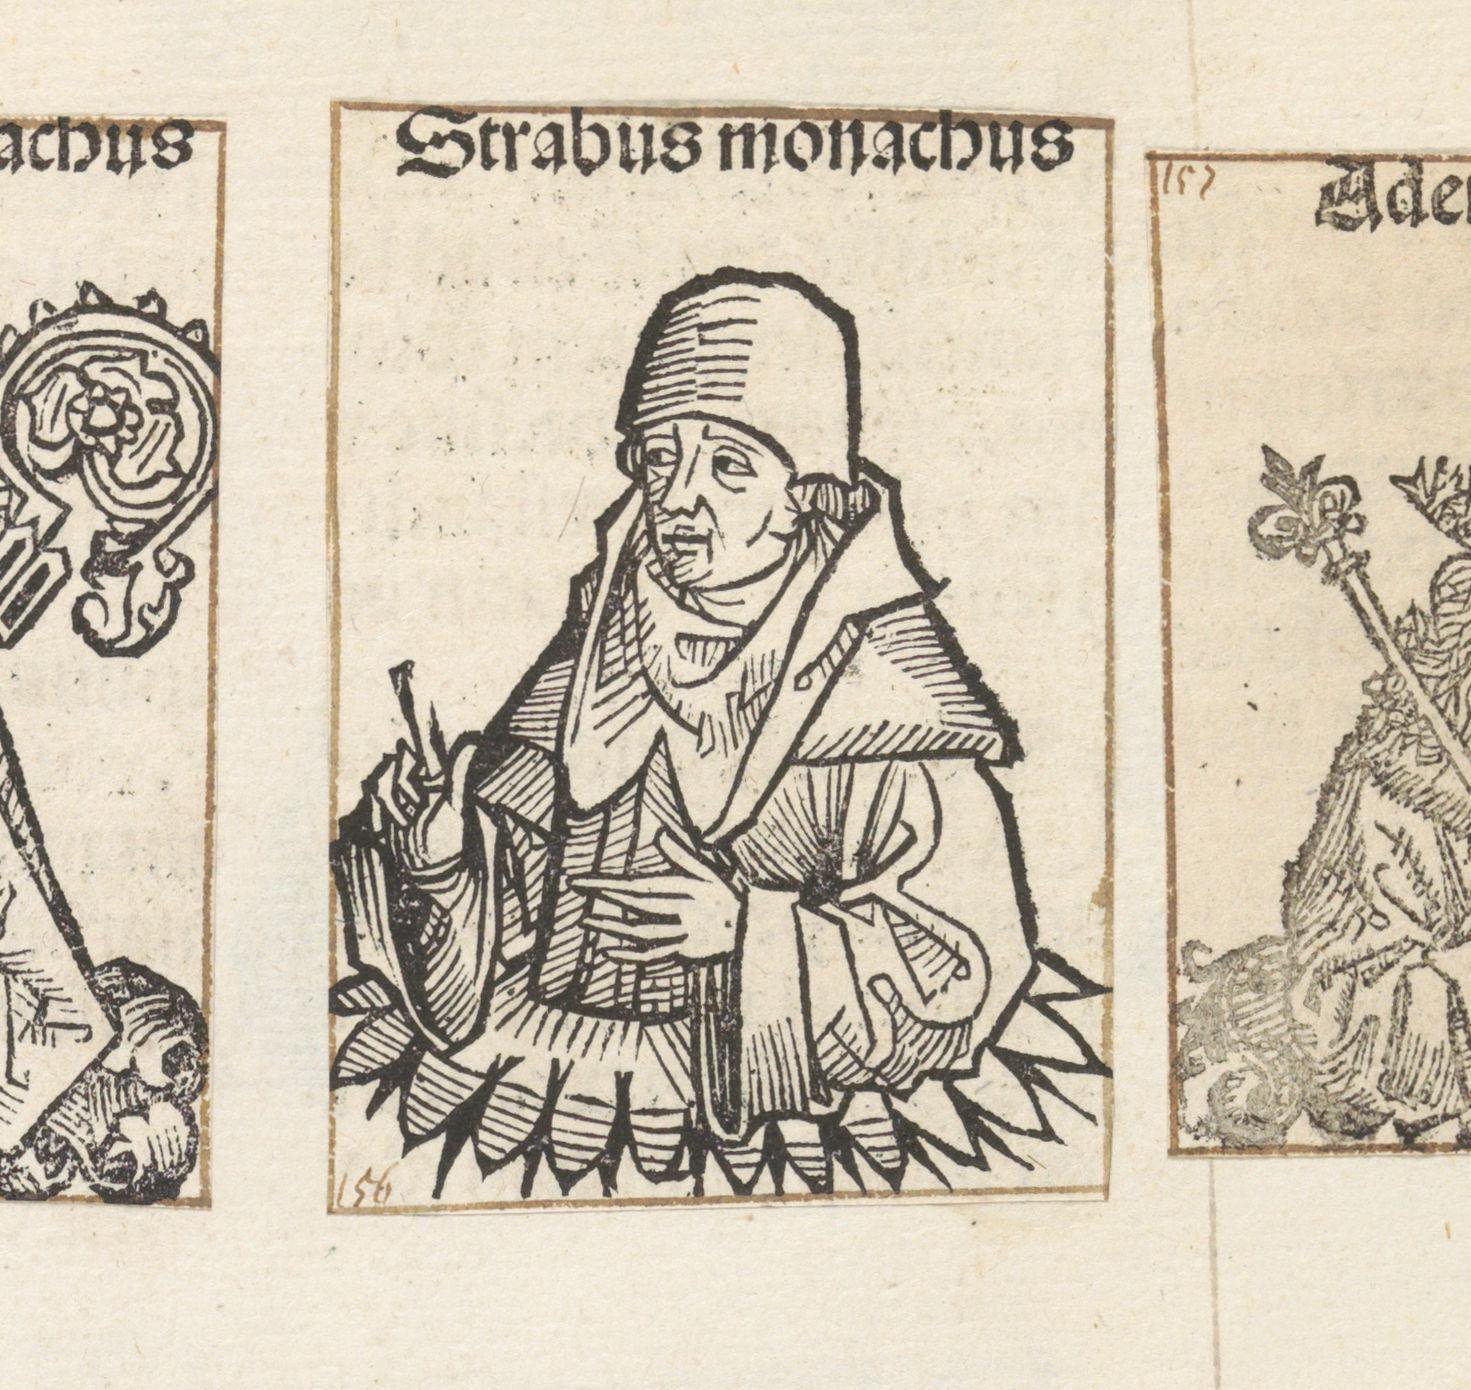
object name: book illustration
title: Walahfrid Strabo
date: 1493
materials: paper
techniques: letterpress printing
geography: nuremberg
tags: archbishop, bishop, etc. (roman catholic)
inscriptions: inscription: ‘156’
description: De houtsnede wordt herhaaldelijk gebruikt als boekillustratie in de Liber Chronicarum (of Neurenbergkroniek) van Hartmann Schedel, verschenen in het Latijn en Duits in 1493. Zie de Latijnse uitgave, folio 169r.